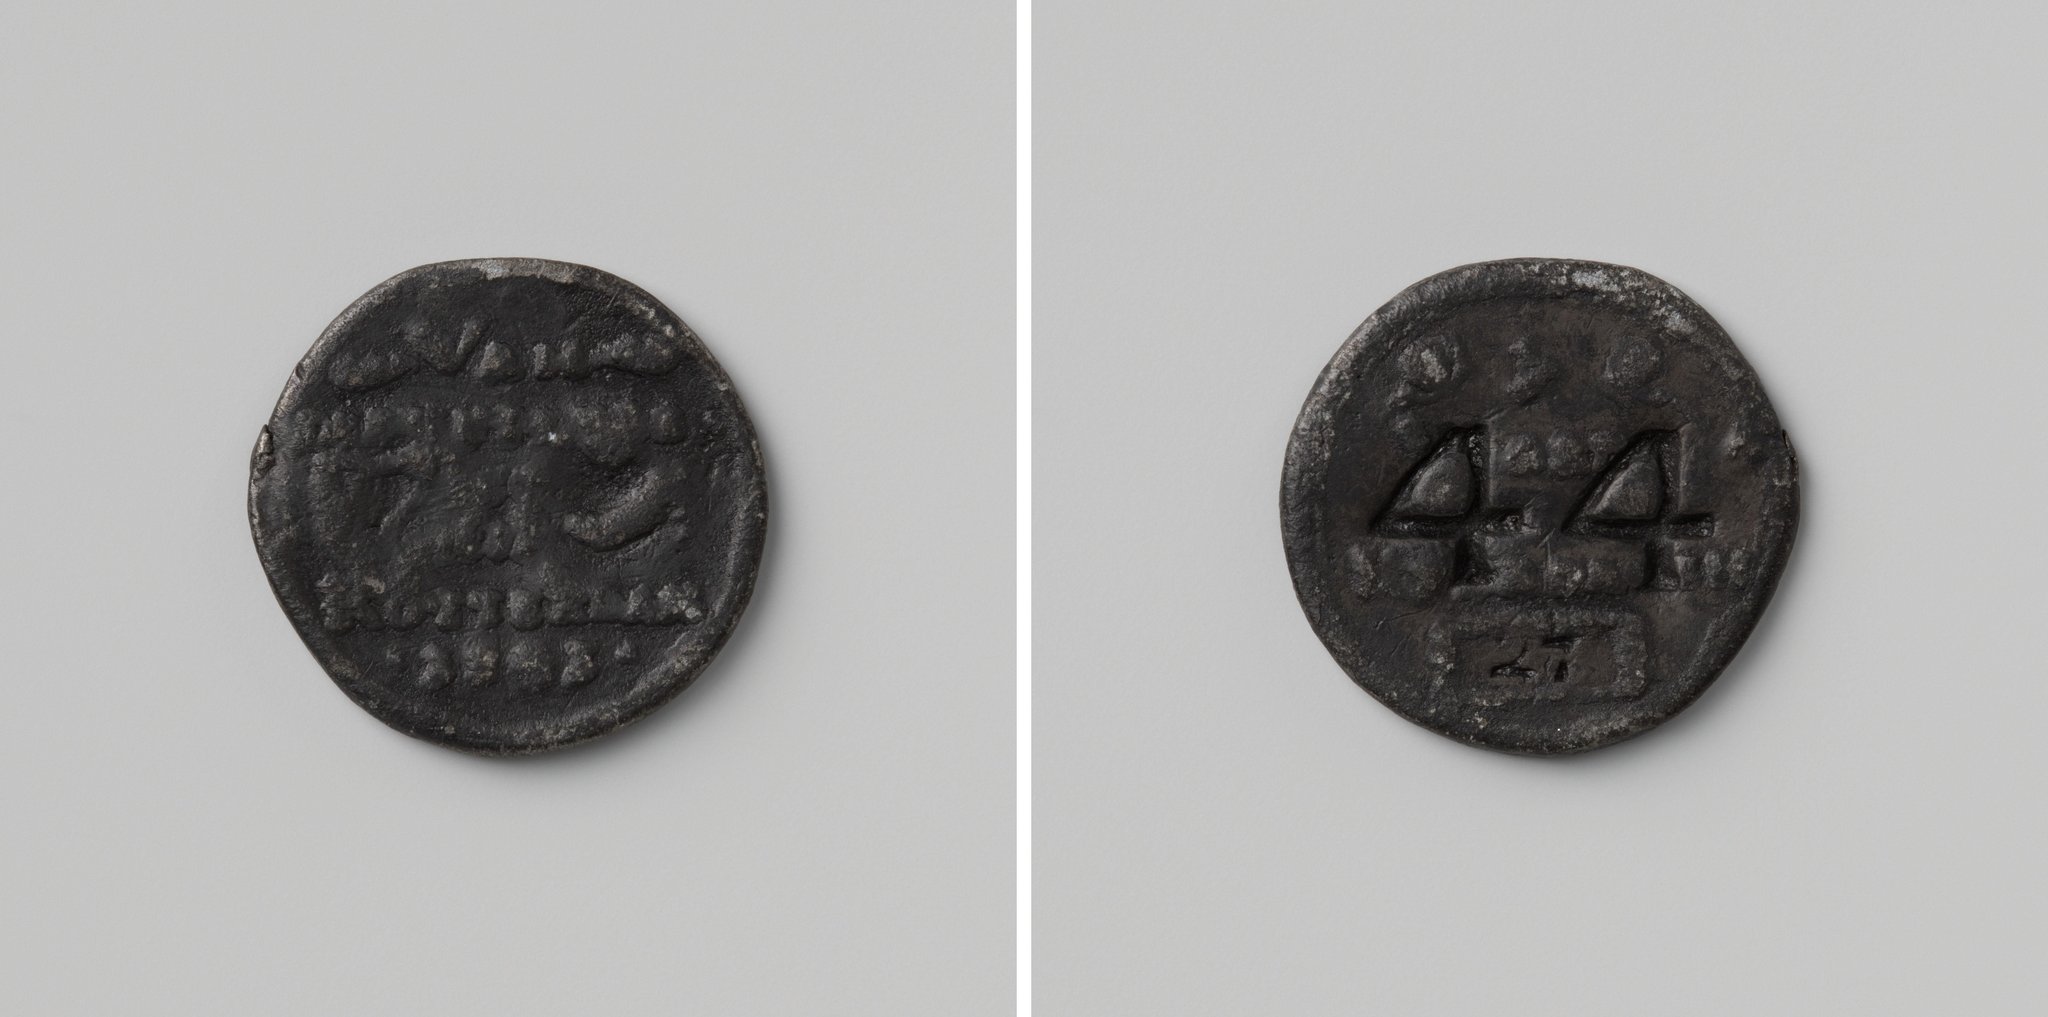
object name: medal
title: Schoenmakersgilde [?] van Rotterdam, gildepenning met nrs. 44 en 27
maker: Anonymous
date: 1650-1800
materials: lead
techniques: casting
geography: rotterdam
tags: rotterdam